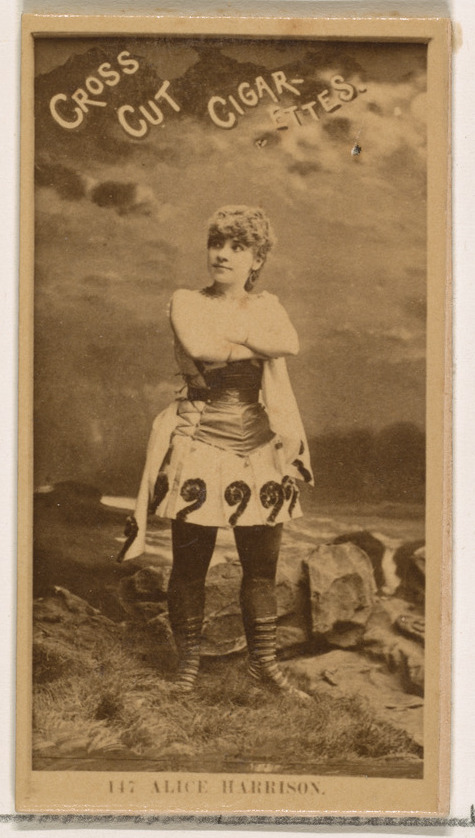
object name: print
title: Card Number 147, Alice Harrison, from the Actors and Actresses series (N145-2) issued by Duke Sons & Co. to promote Cross Cut Cigarettes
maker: w. duke, sons & co.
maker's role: publisher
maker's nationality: american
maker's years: 1870-1920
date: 1880-1889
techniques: albumen silver print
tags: portraits,women,actresses